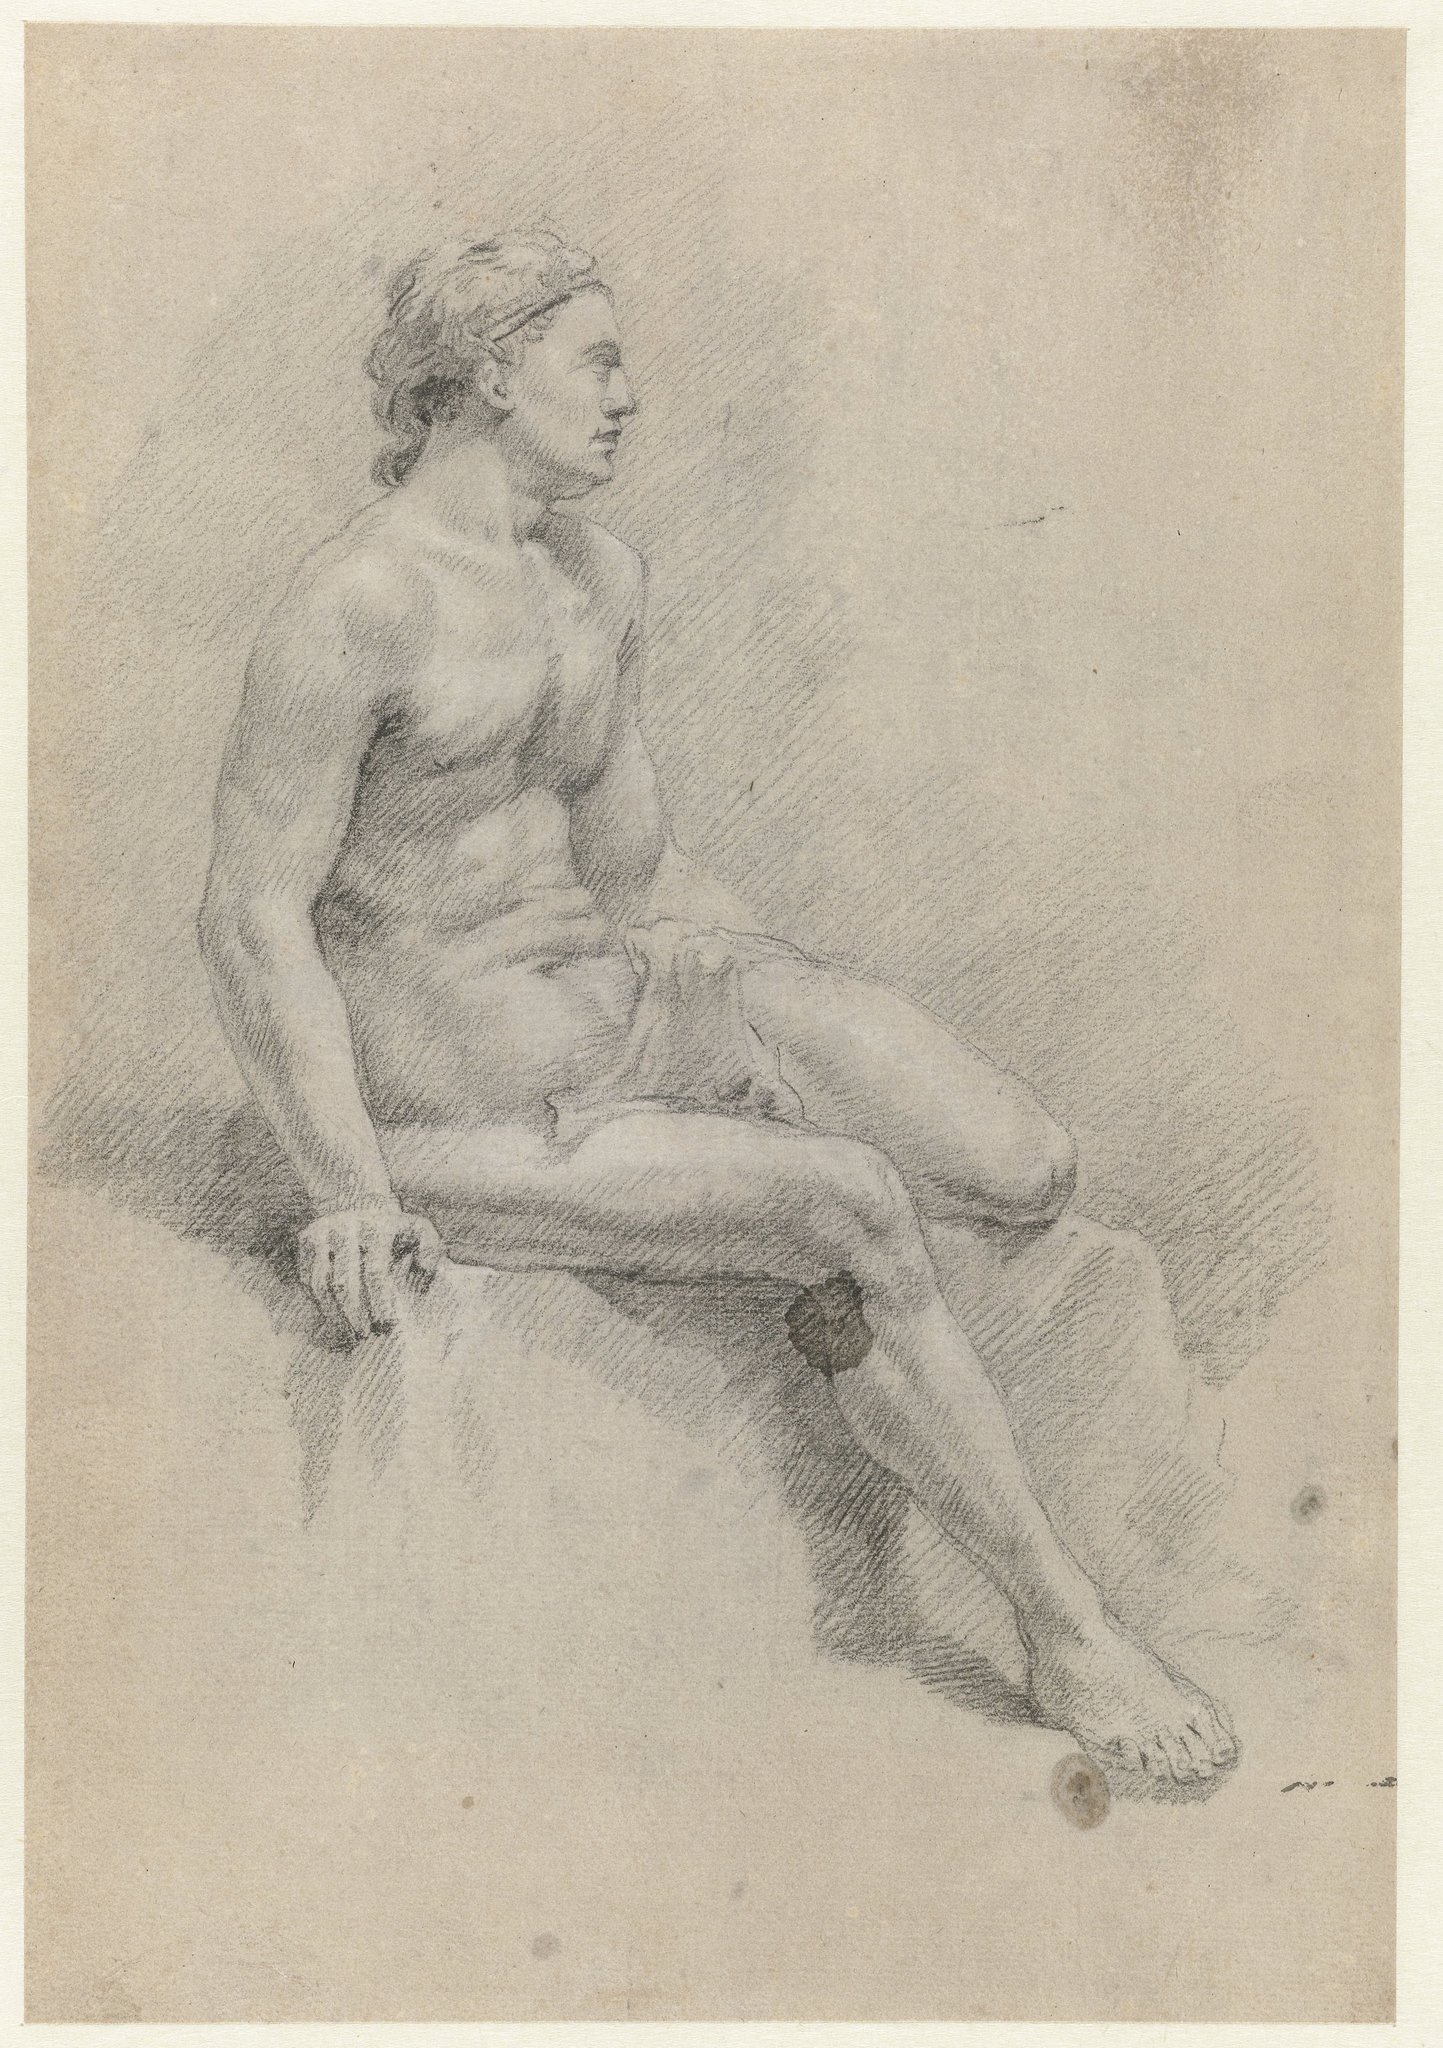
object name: drawing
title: Zittend mannelijk naakt, steunend op een arm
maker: jan hoogsaat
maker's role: painter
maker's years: 1654-1750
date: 1664-1730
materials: chalk, paper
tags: sitting figure, human figure of ideal proportions, e.g. academic nude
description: Zittend mannelijk naakt, steunend op een arm en met een been gevouwen.